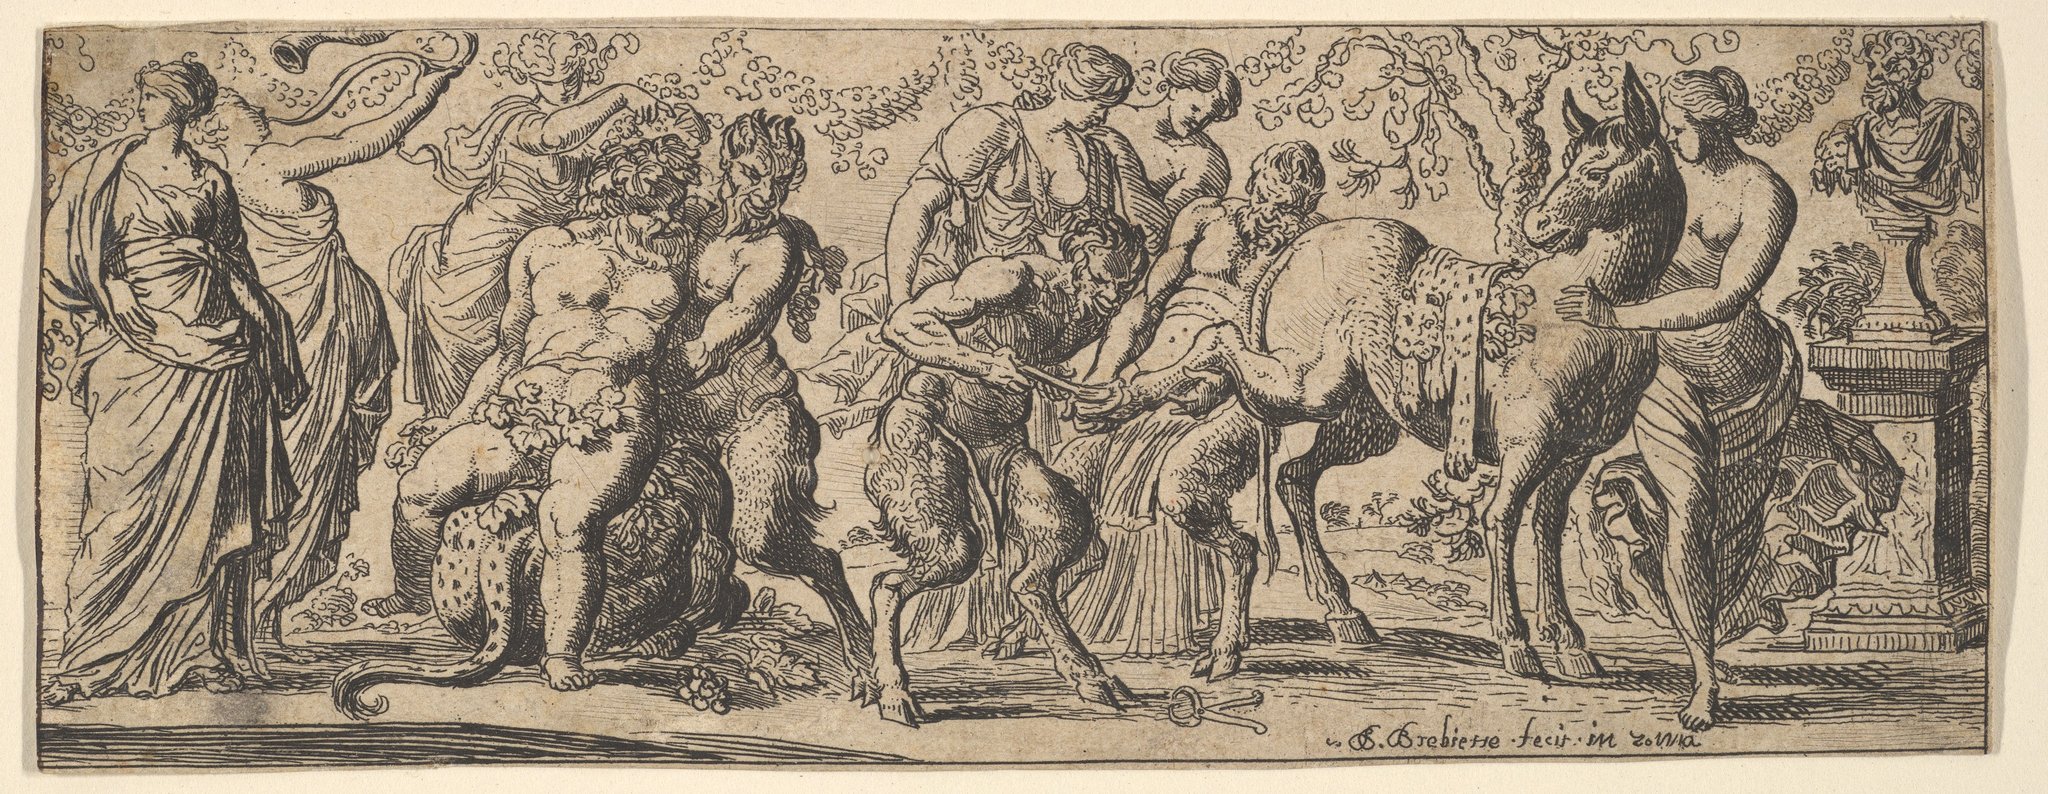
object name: print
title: Bacchanale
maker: pierre brebiette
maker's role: artist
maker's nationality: french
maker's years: 1598-1642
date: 1610-1642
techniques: etching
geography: france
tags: men,women,centaurs,bacchus,horses